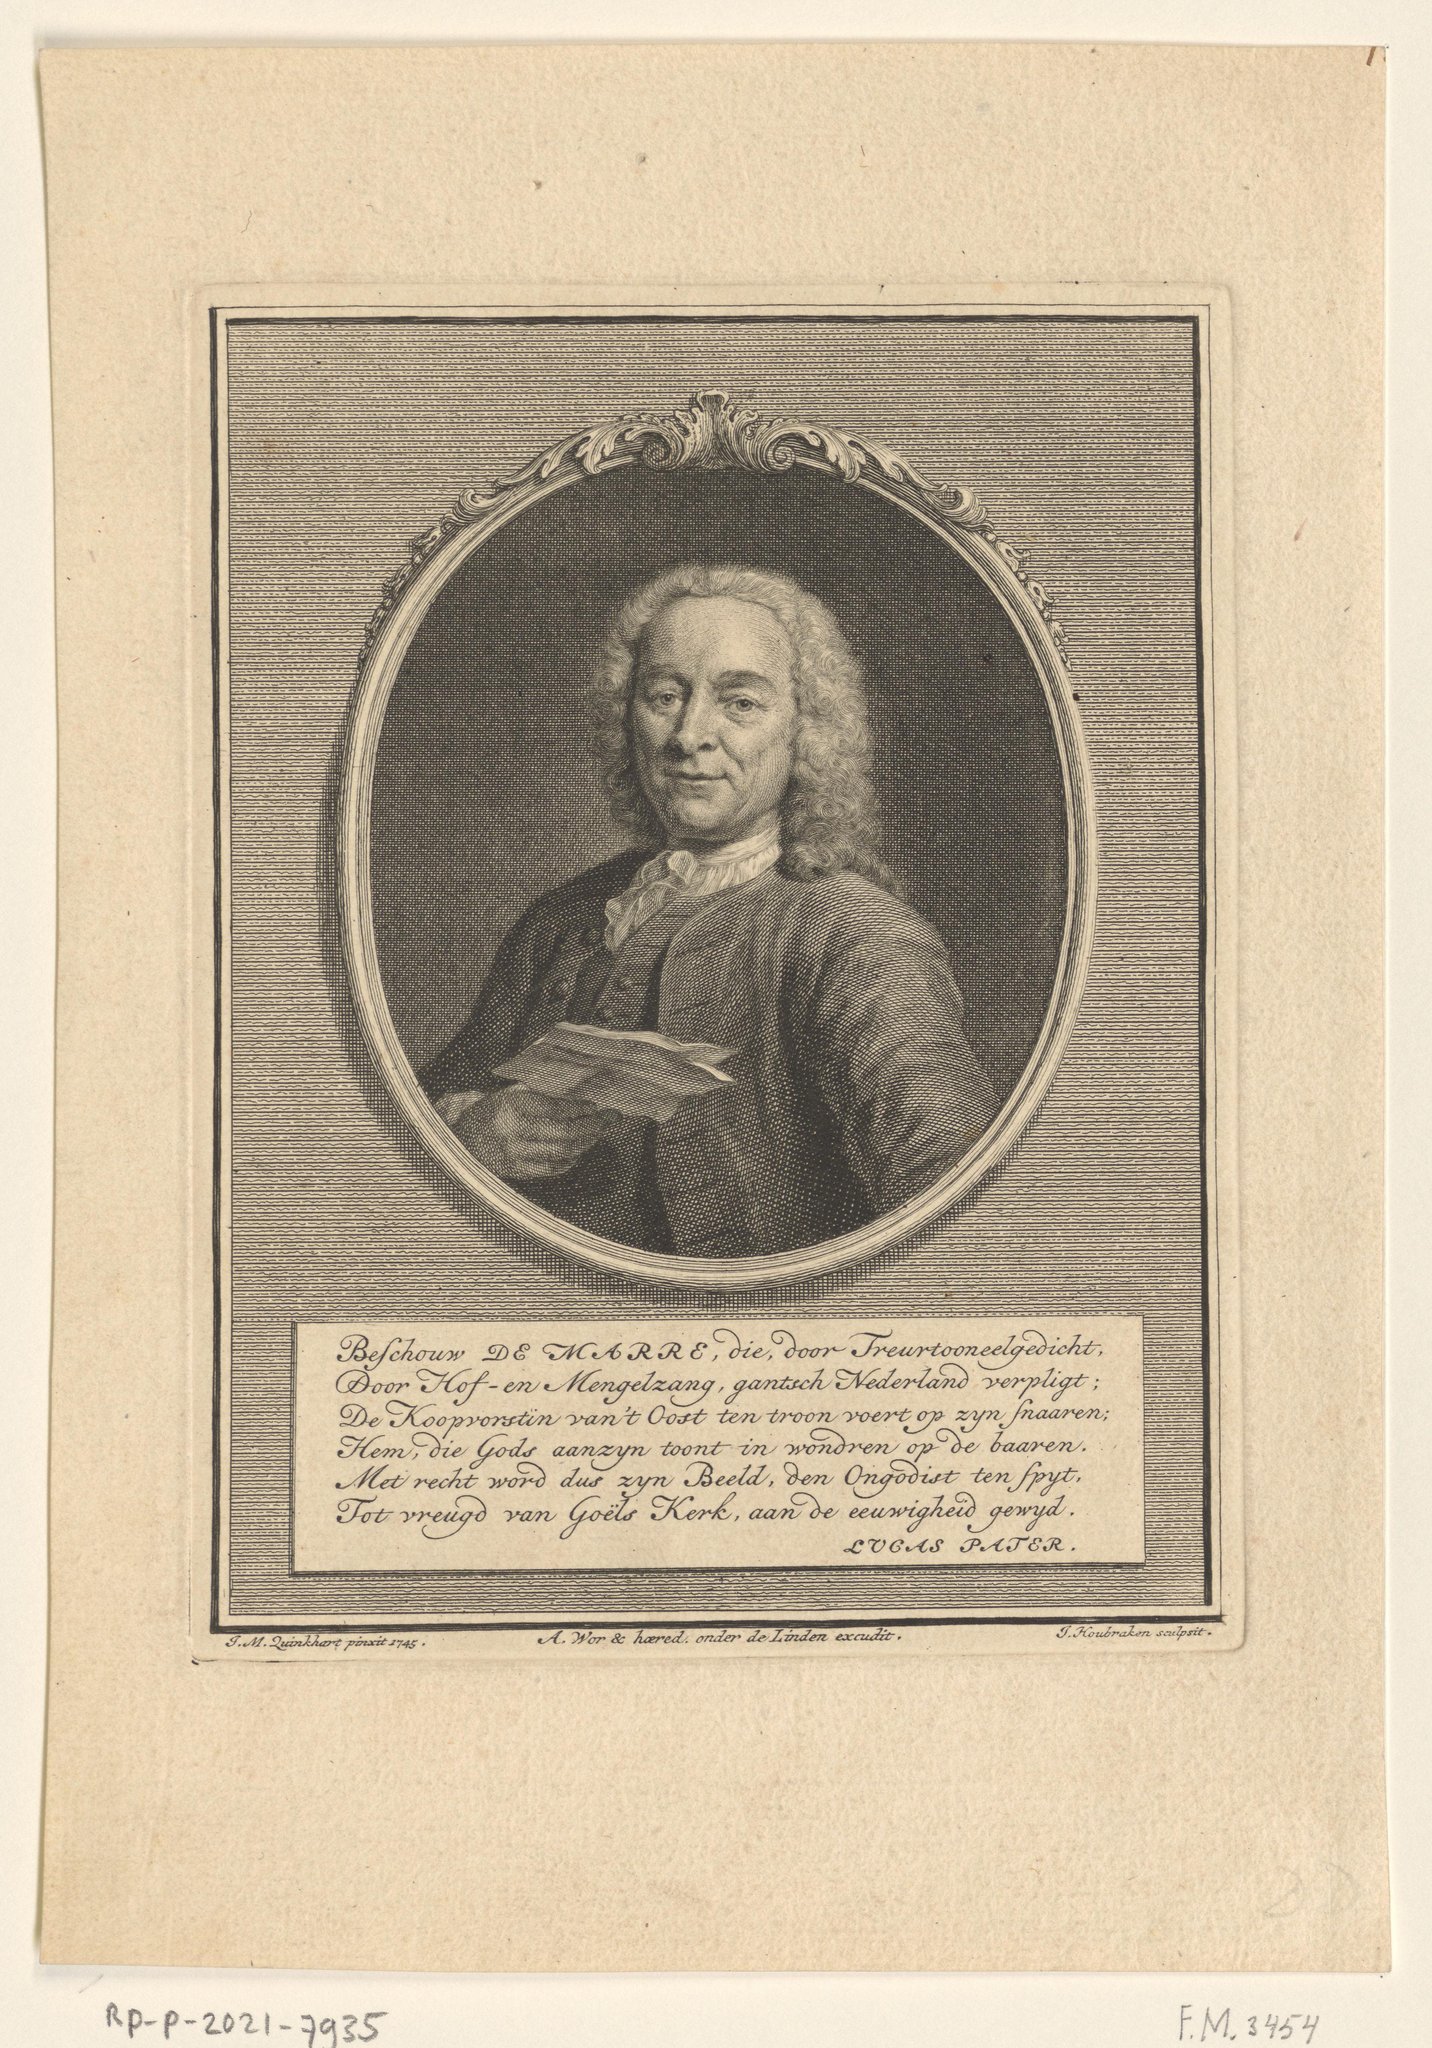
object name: print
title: Portret van Jan de Marre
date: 1745-1750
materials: paper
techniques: engraving, etching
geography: amsterdam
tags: ornament ~ medallion, historical persons, portrait of a writer